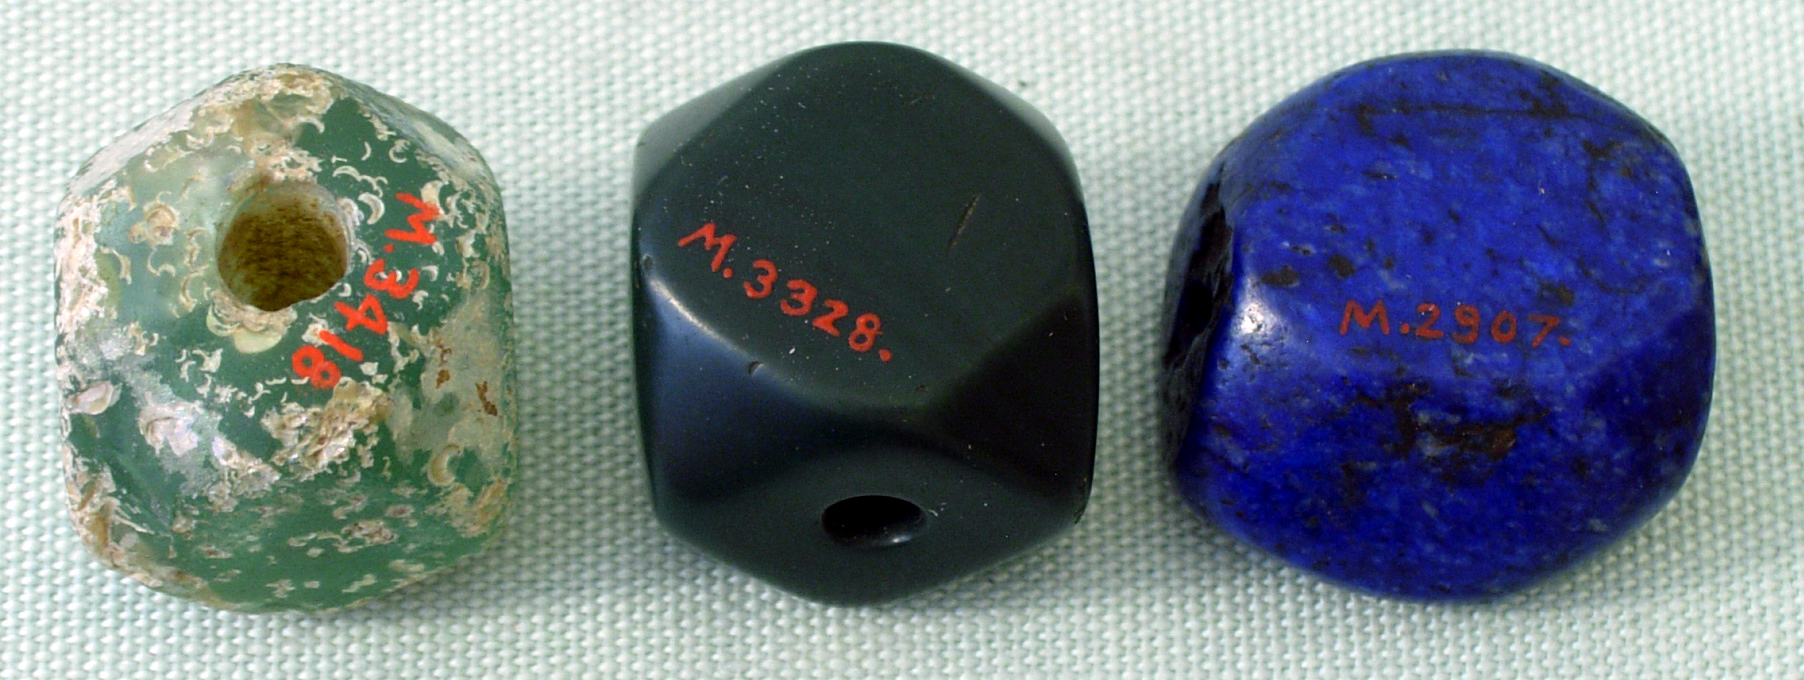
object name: bead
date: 801-1200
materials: glass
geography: egypt